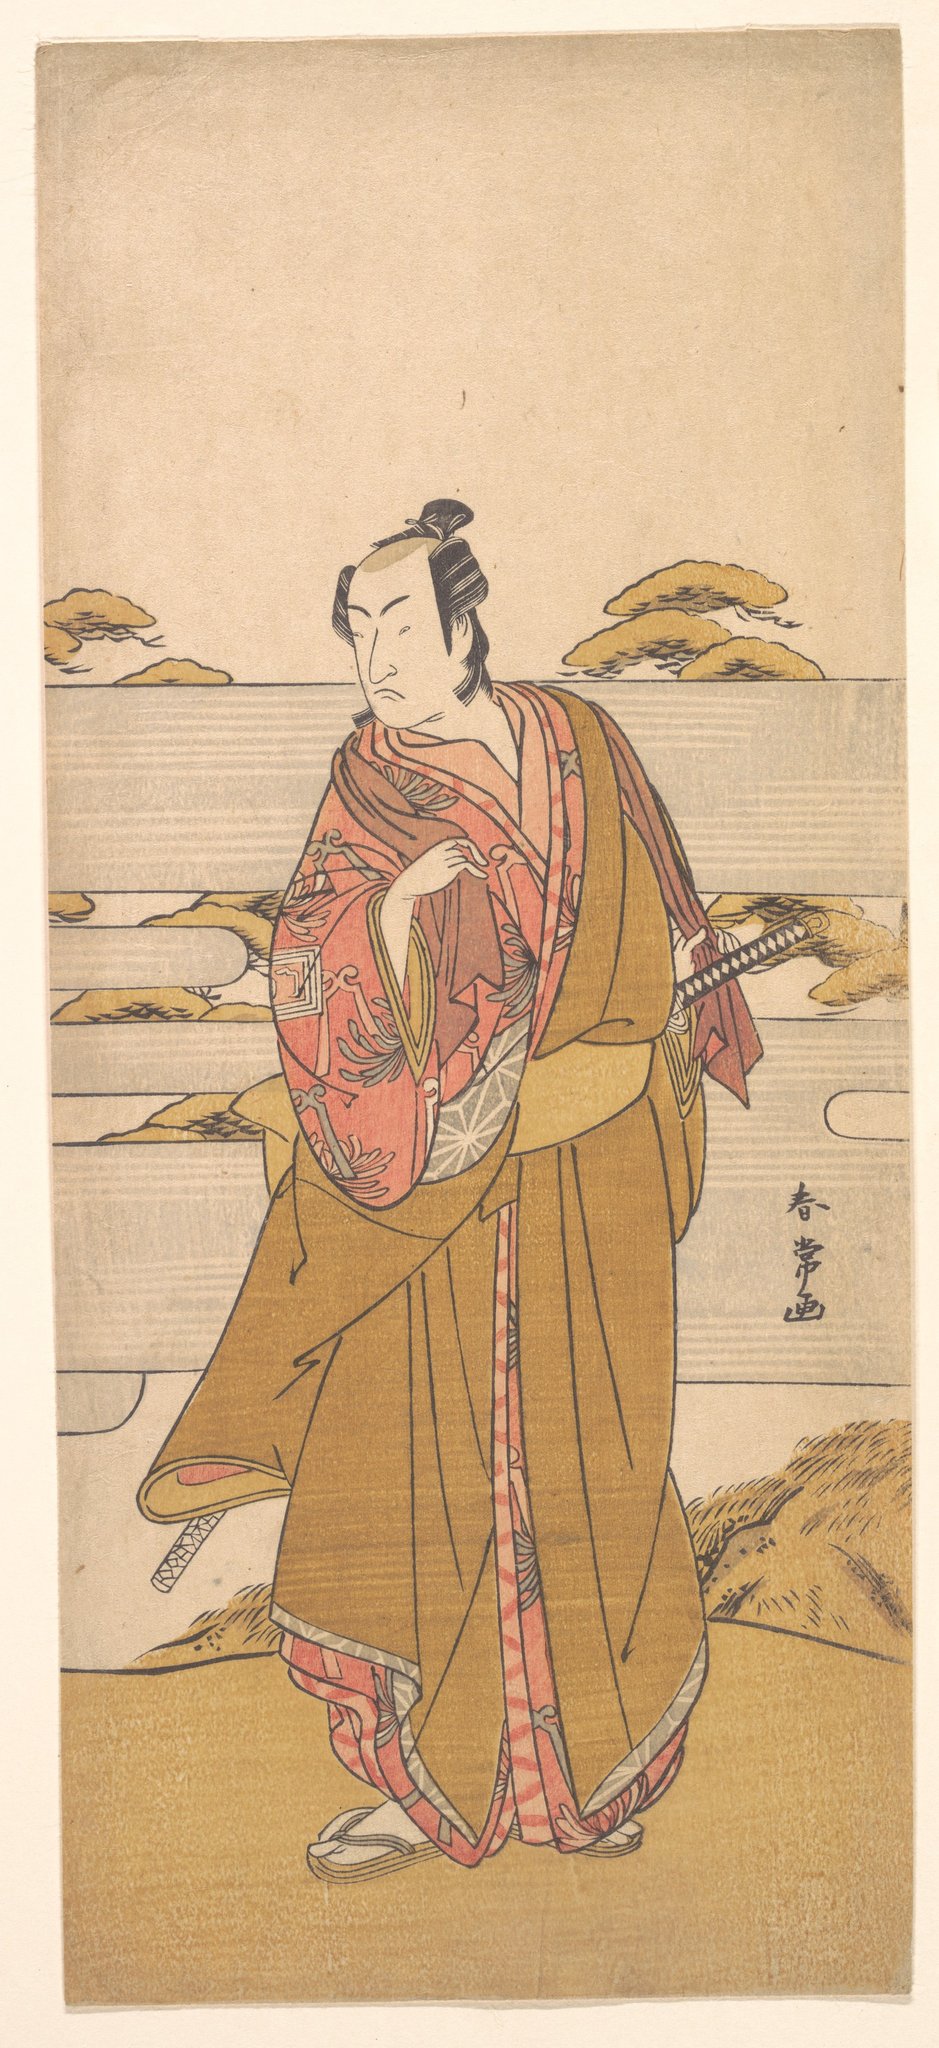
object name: print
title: Ichikawa Monosuke II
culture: japanese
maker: katsukawa shunjō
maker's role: artist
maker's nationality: japanese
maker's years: 1700-1787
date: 1790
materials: ink, paper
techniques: woodblock print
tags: men,actors